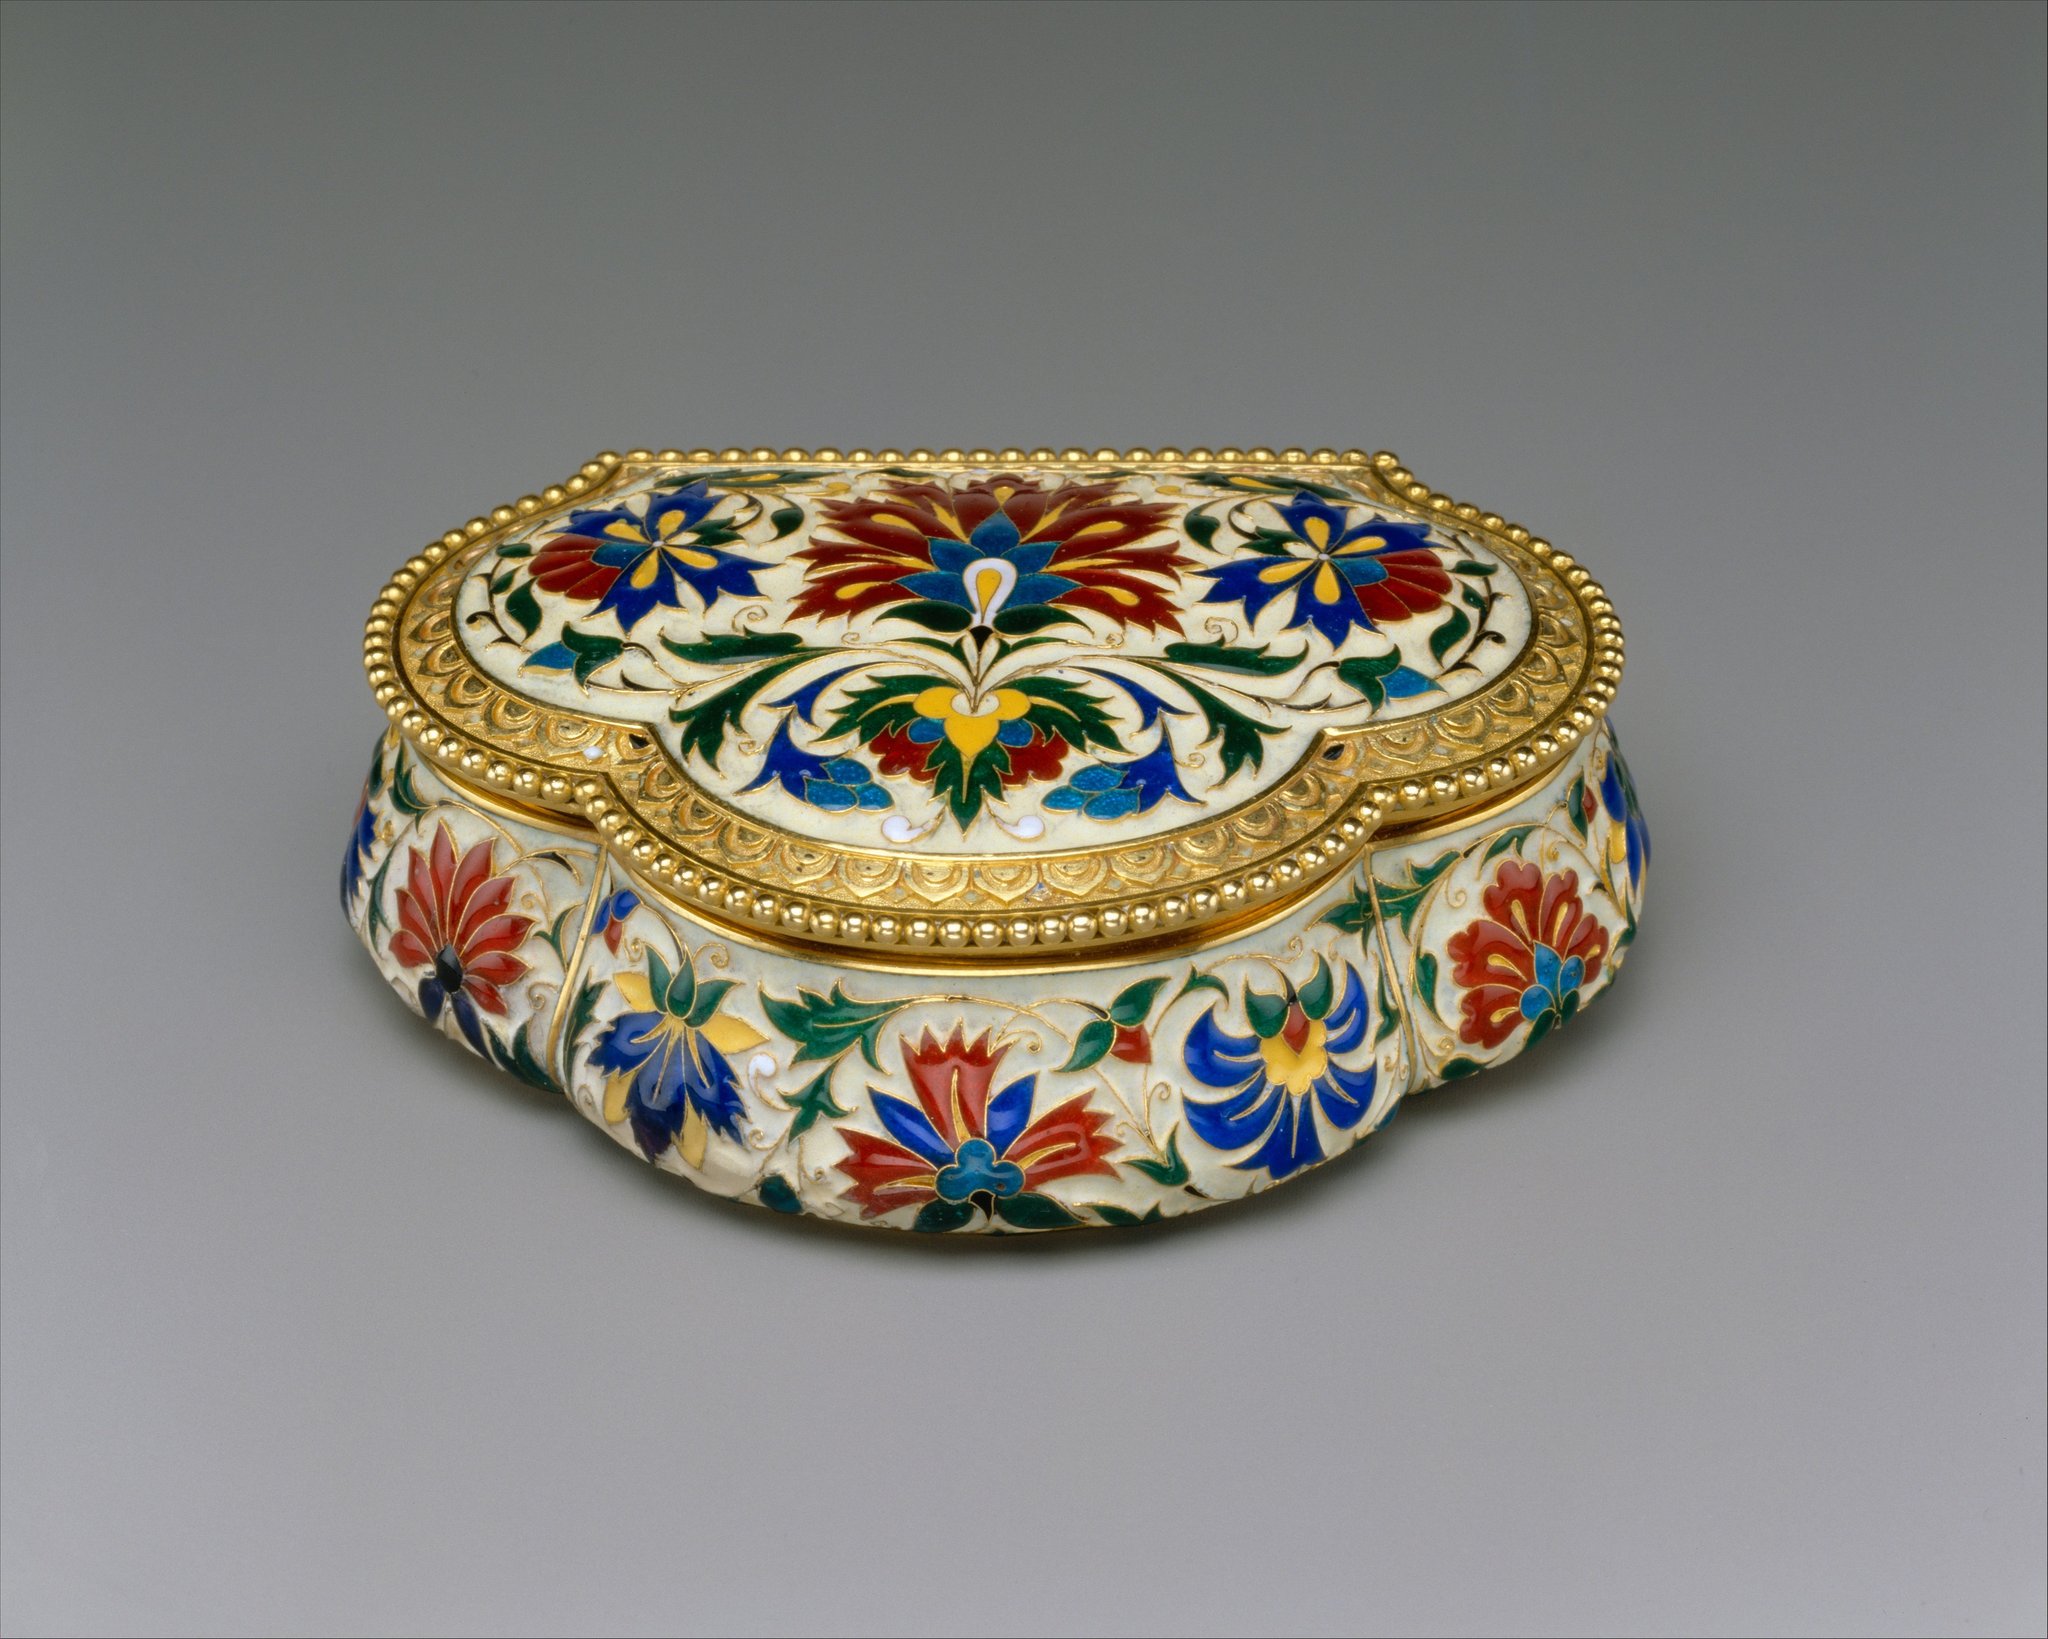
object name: box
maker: lucien falize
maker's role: maker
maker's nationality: french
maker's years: 1839-1897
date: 1875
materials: enamel, gold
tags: flowers